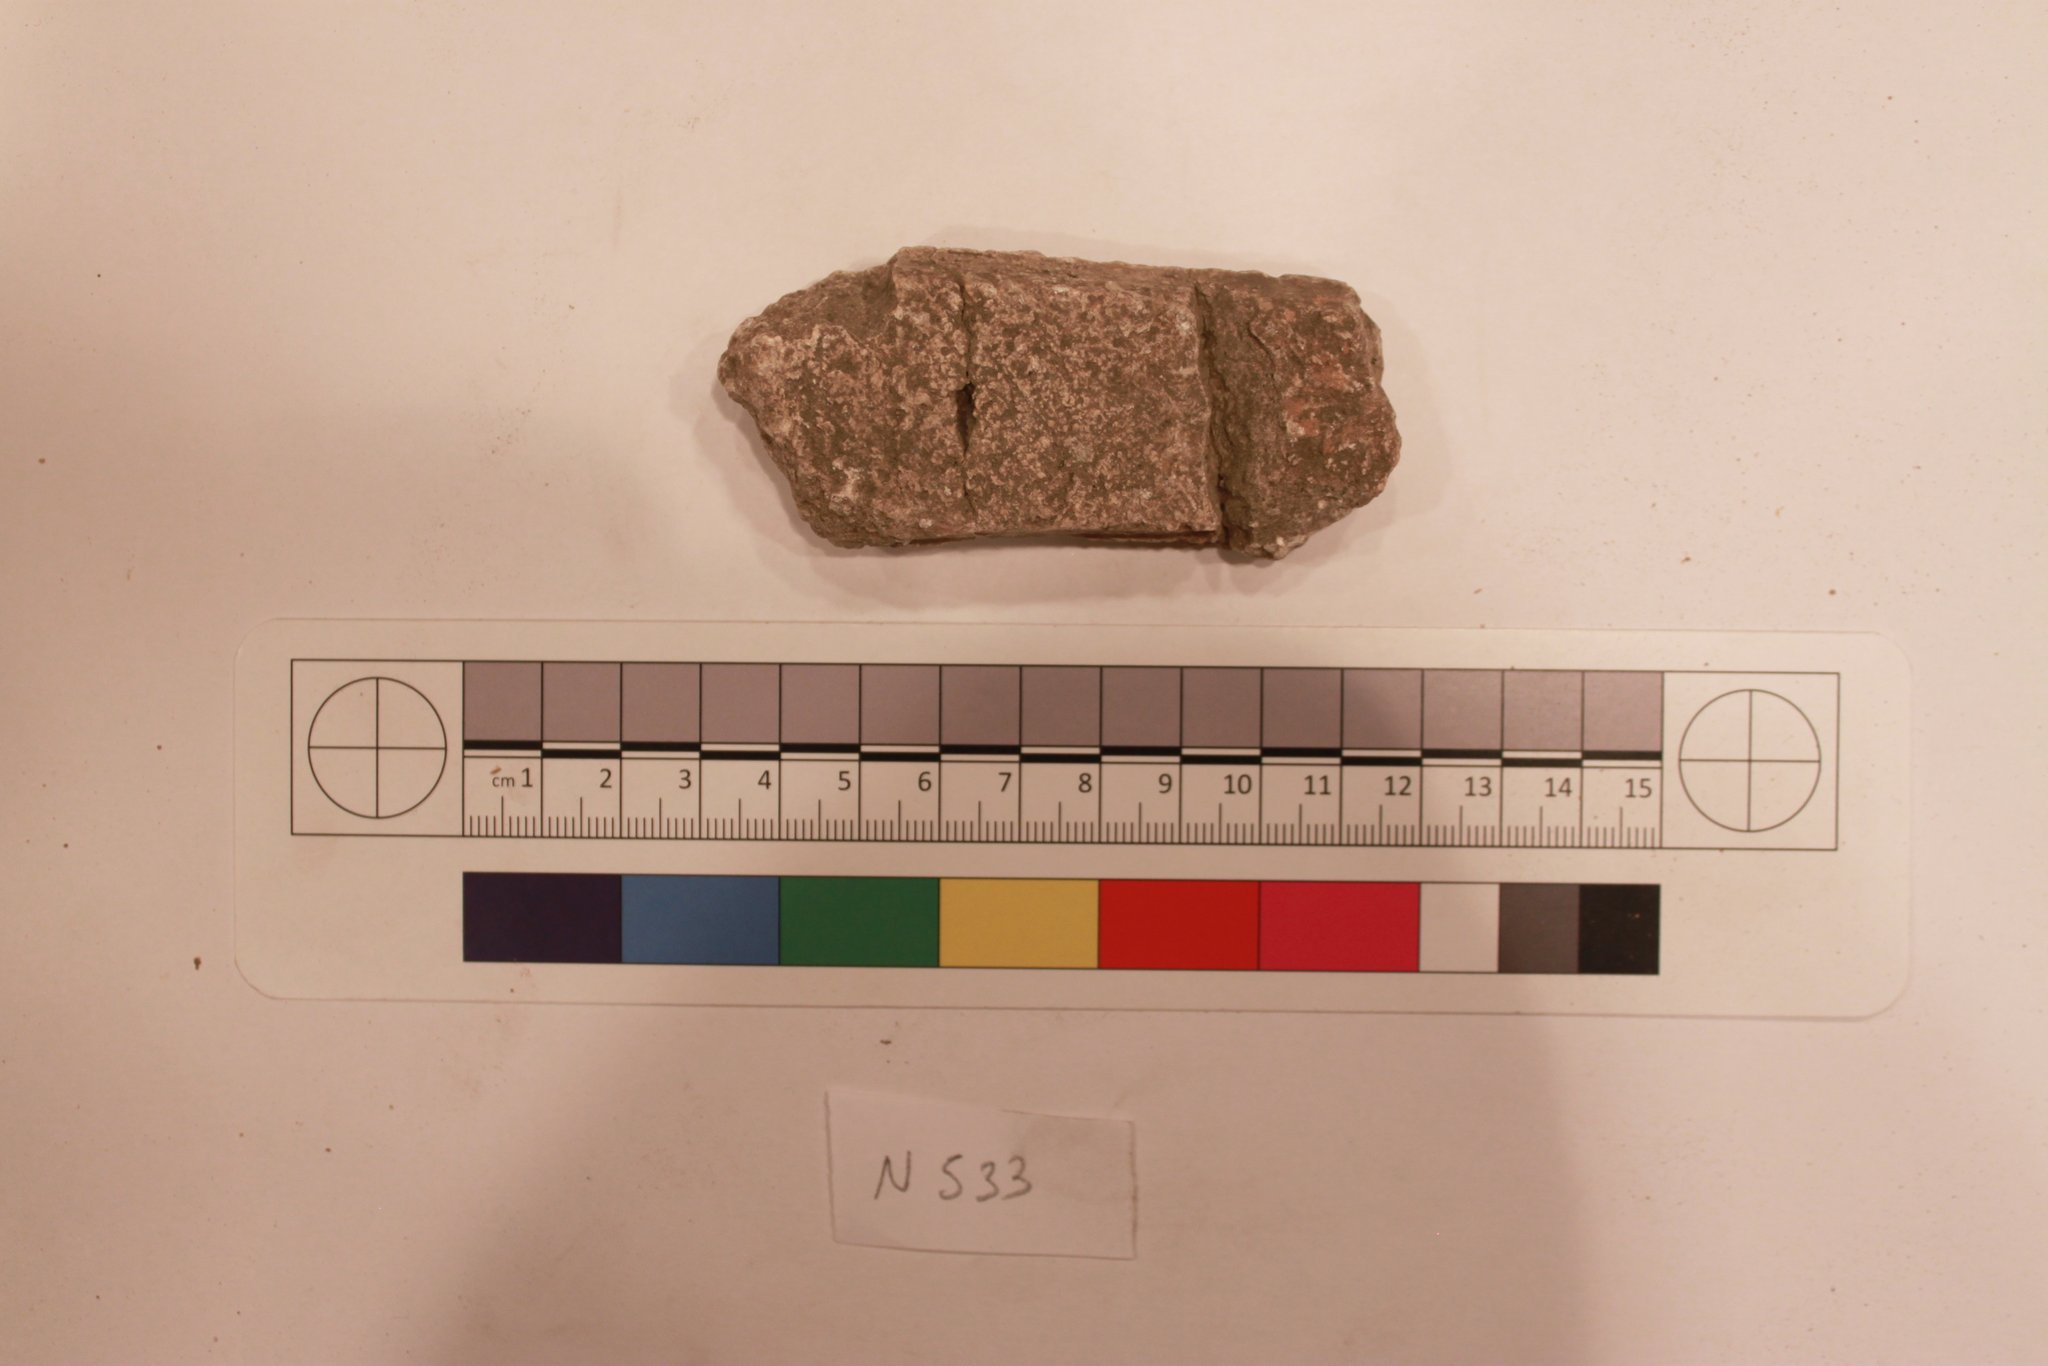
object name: fragment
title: Stucco Fragment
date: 701-1200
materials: plaster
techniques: carving, painting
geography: iran